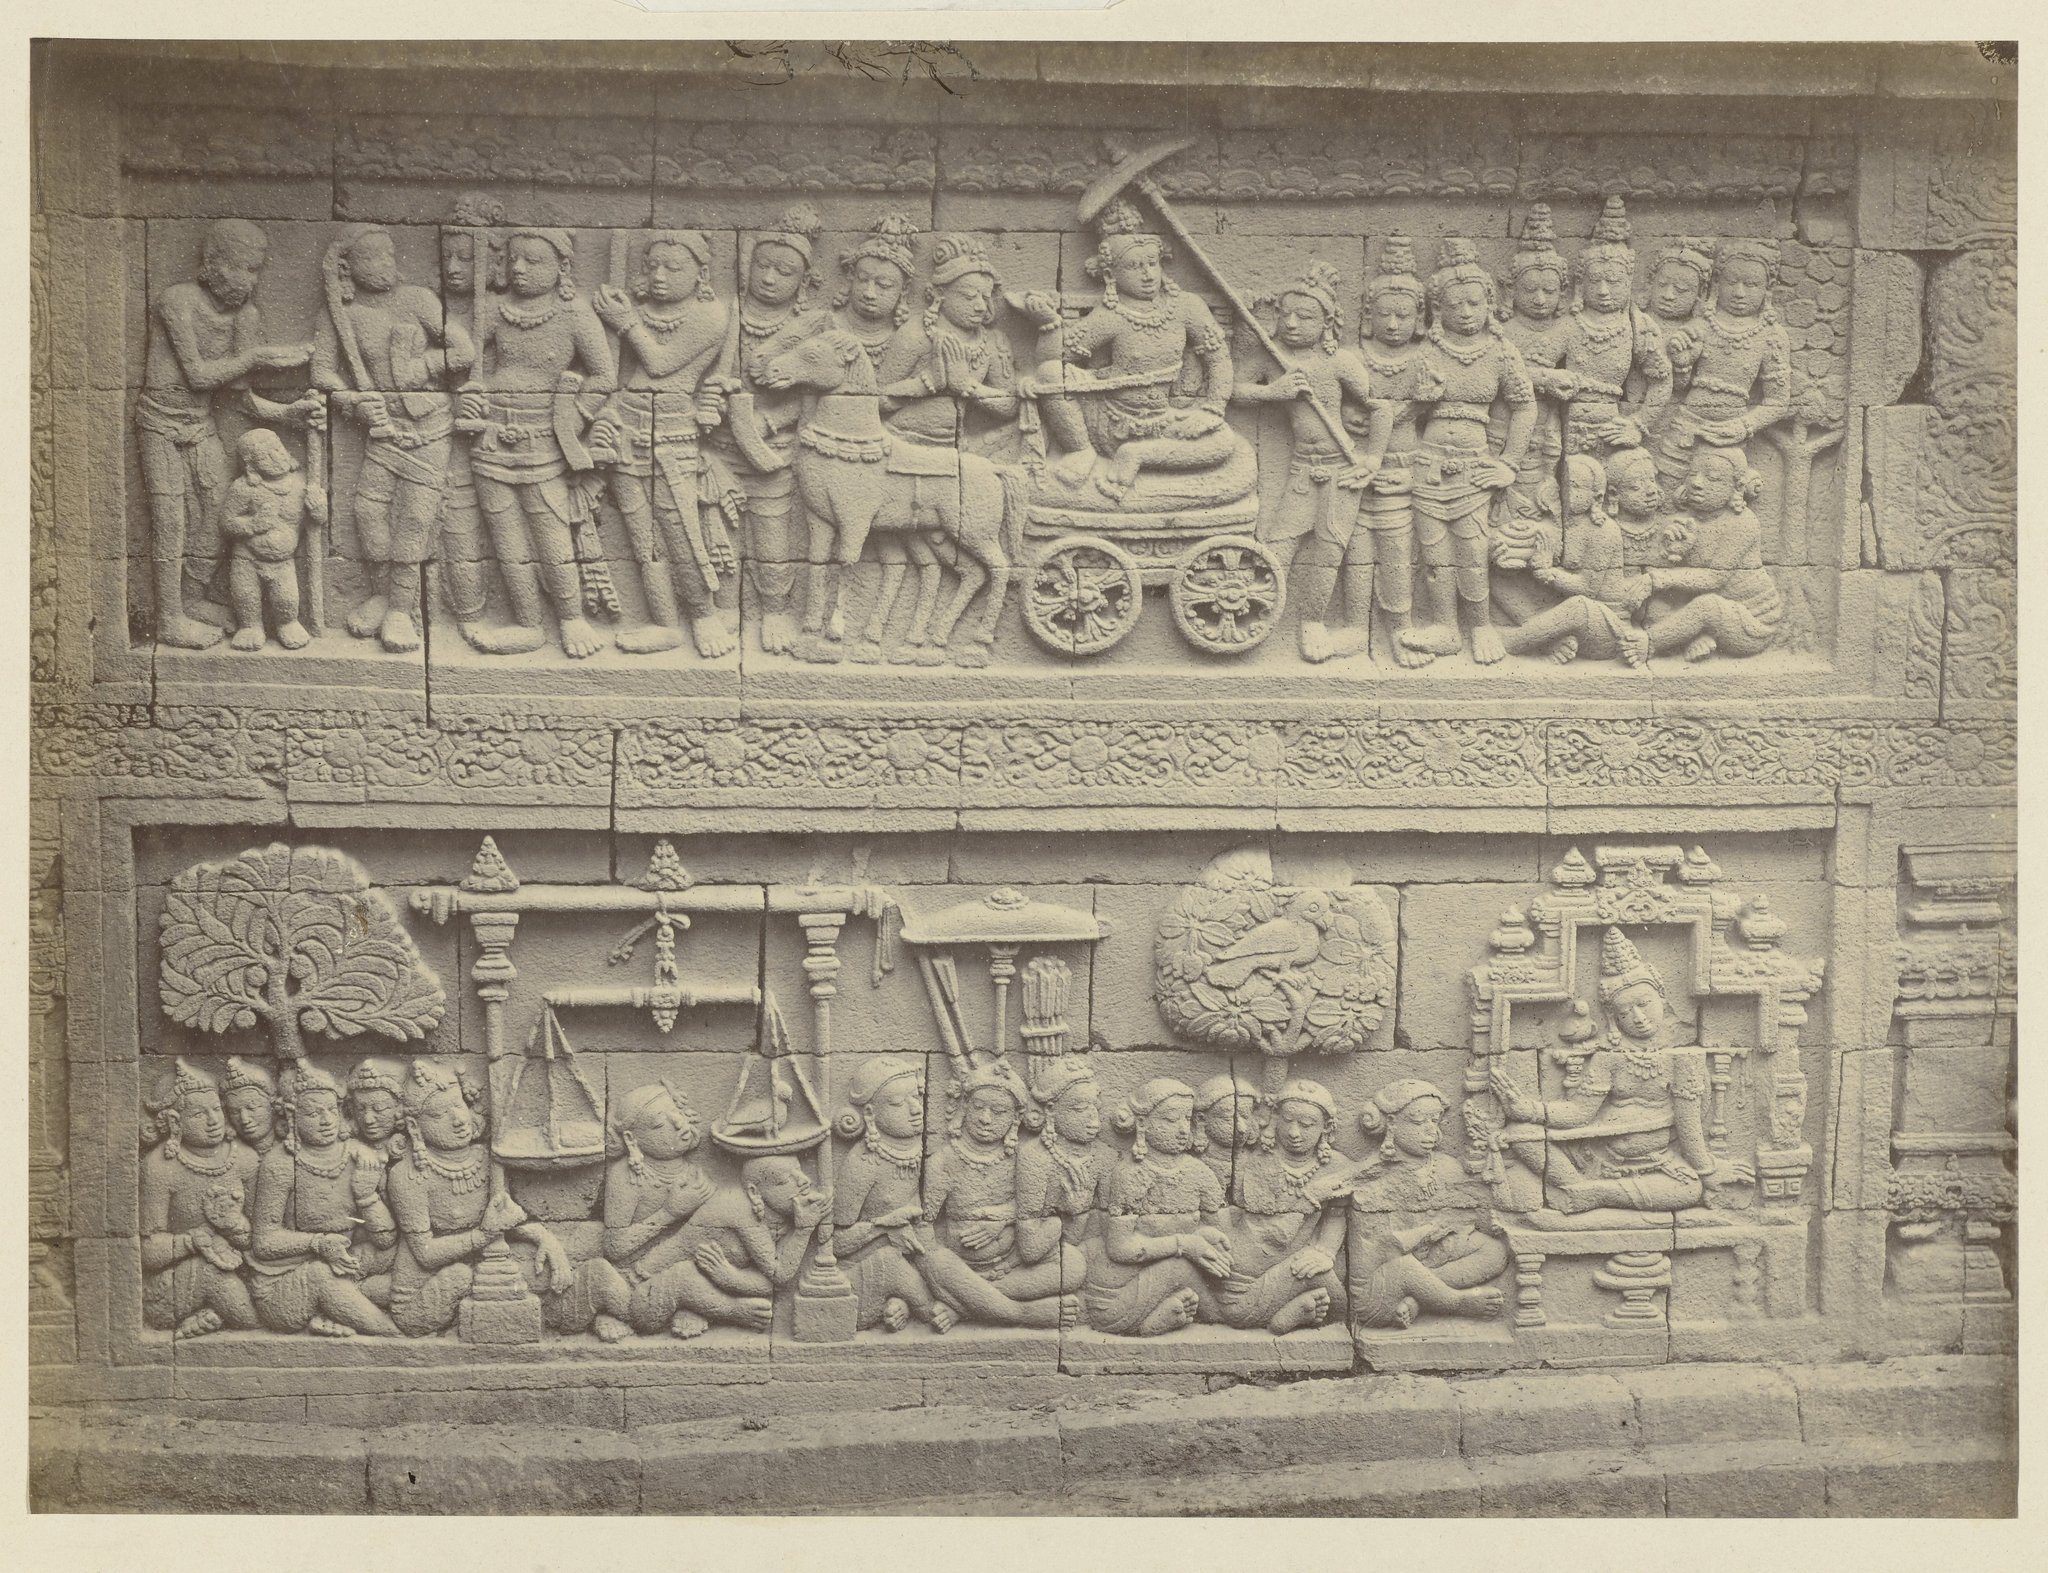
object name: photograph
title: Idem 2e gaanderij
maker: isidore kinsbergen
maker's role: fotograaf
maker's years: 1821-1905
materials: cardboard, paper, photographic support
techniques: albumen print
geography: java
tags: borobudur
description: Gallery I, main wall, west side 31 (top): Relief 1a-56, Lalitavistara relief, Siddhartha's first encounter: the sight of an old man. 32 (bottom): relief 1b-56, Avadana relief, King Sibi offering his own flesh (left side scale) to save a dove (right side scale) from being eaten by a falcon. Borobudur village, Magelang district, Central Java province, 778-824 AD.